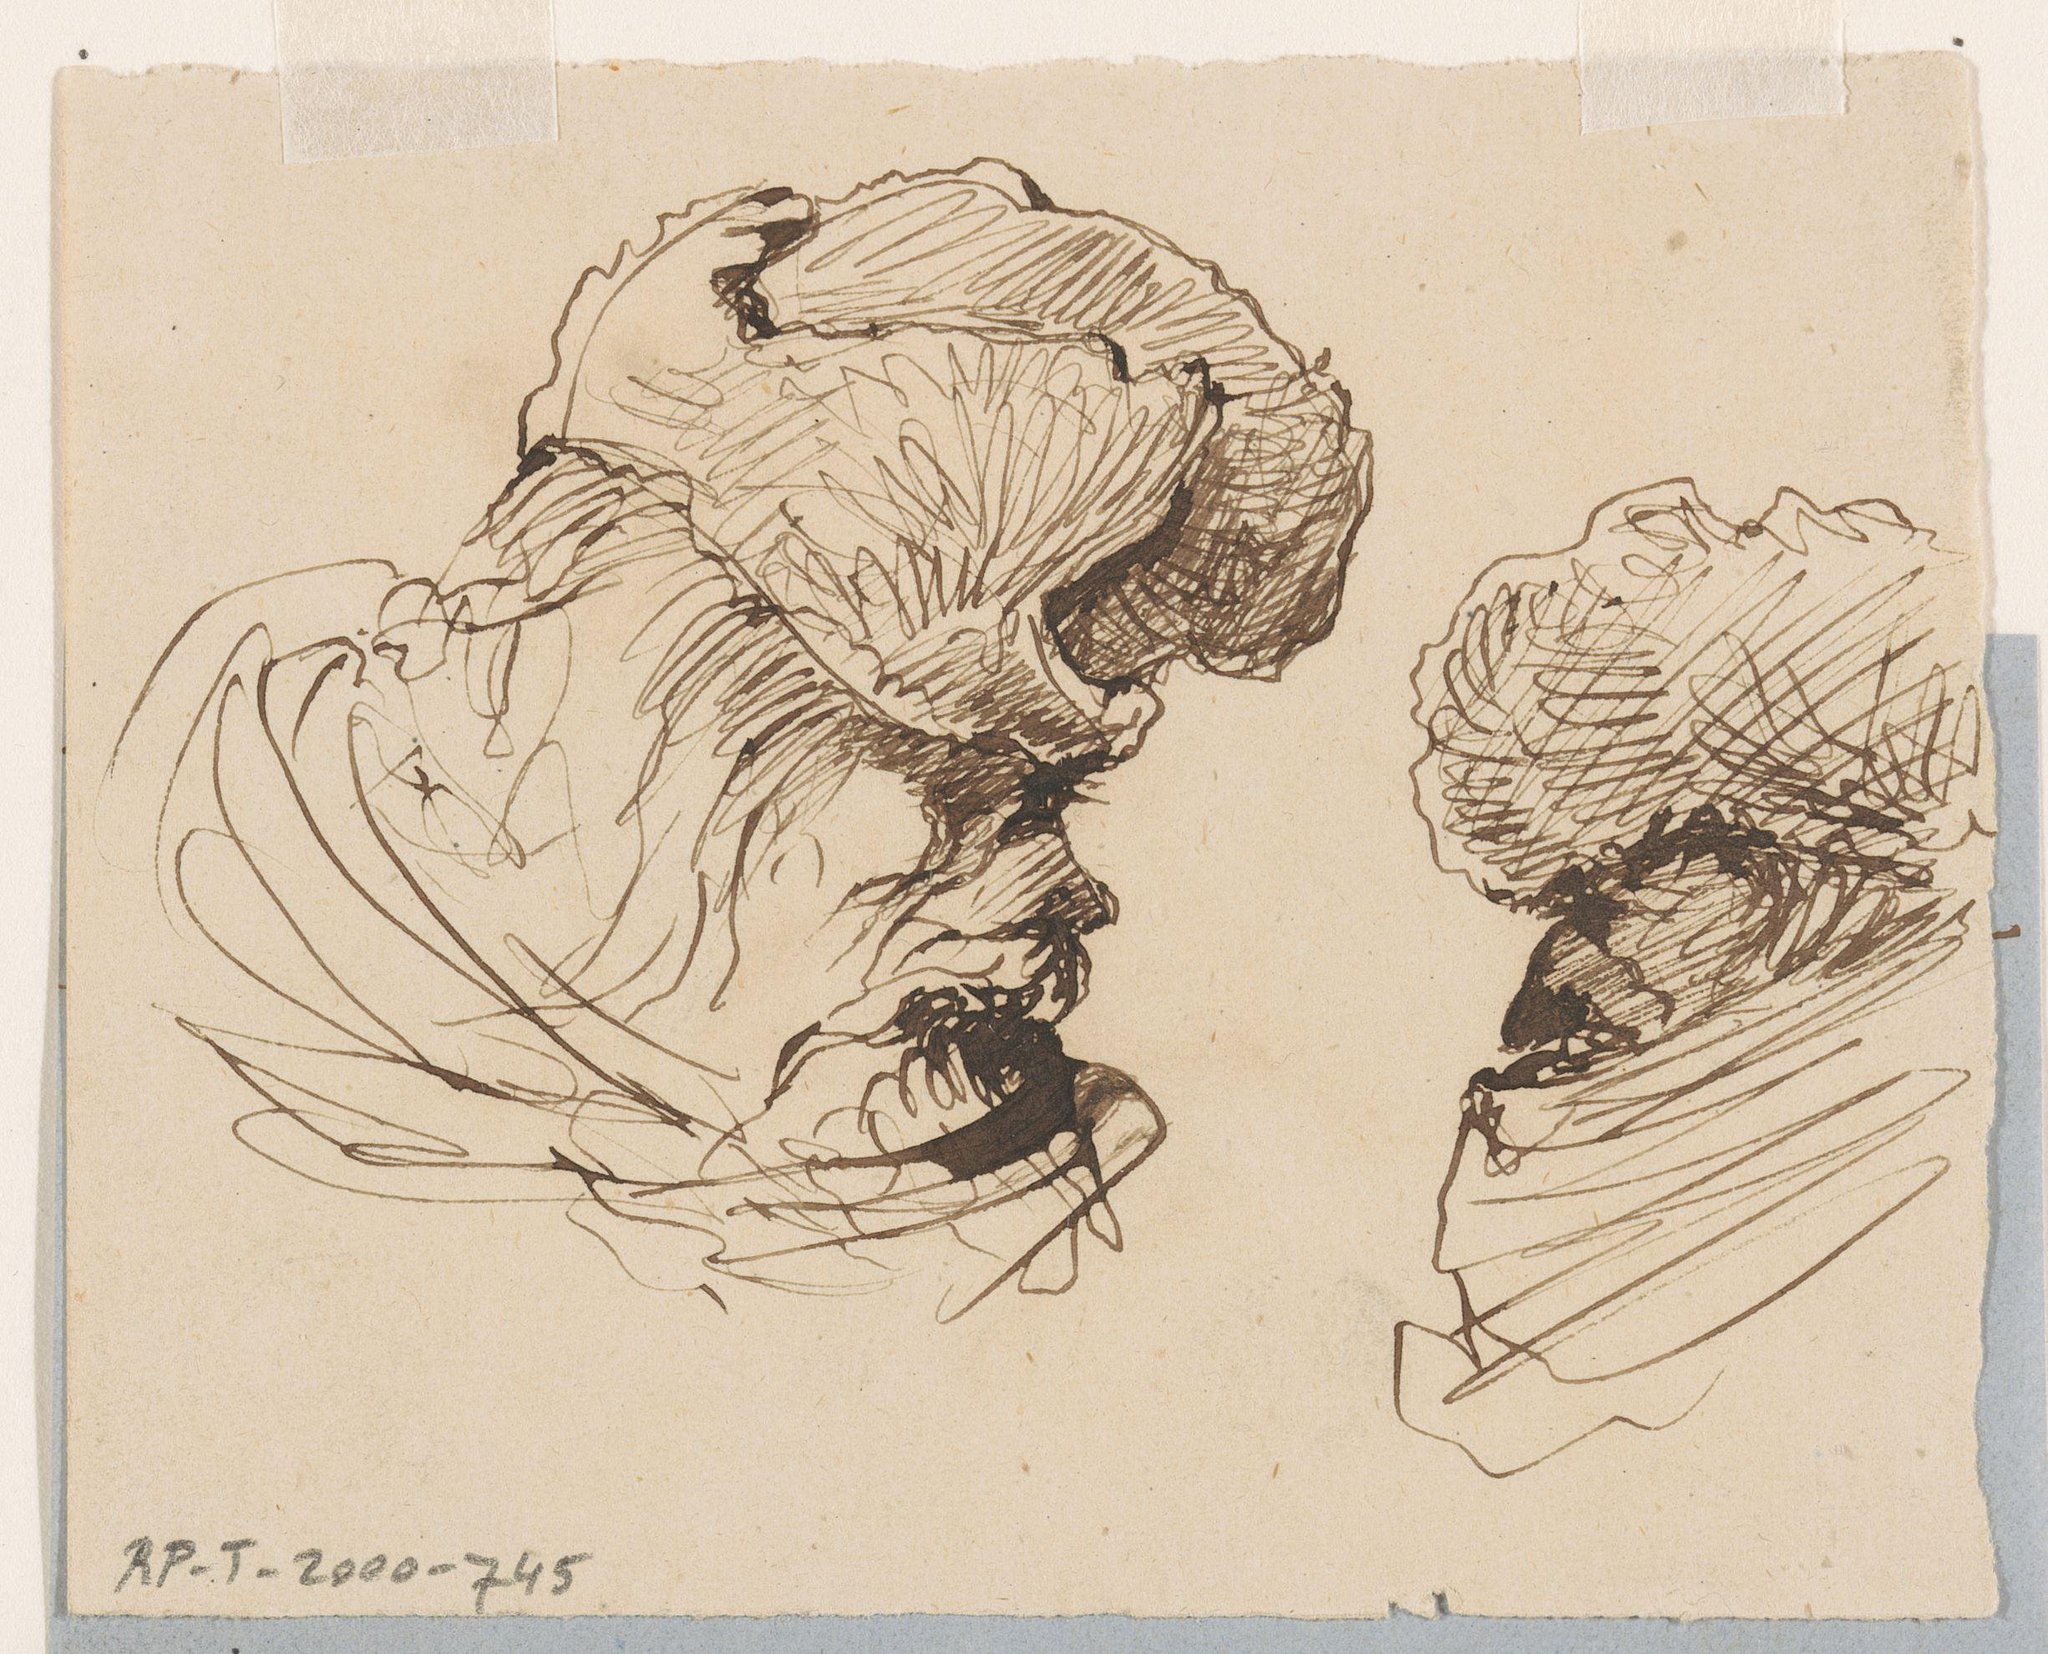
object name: drawing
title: Kop met bontmuts en sjaal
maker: johannes tavenraat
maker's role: draughtsman, painter, print maker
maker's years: 1809-1881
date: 1840-1880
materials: ink, paper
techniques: pen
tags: head-gear (with name)